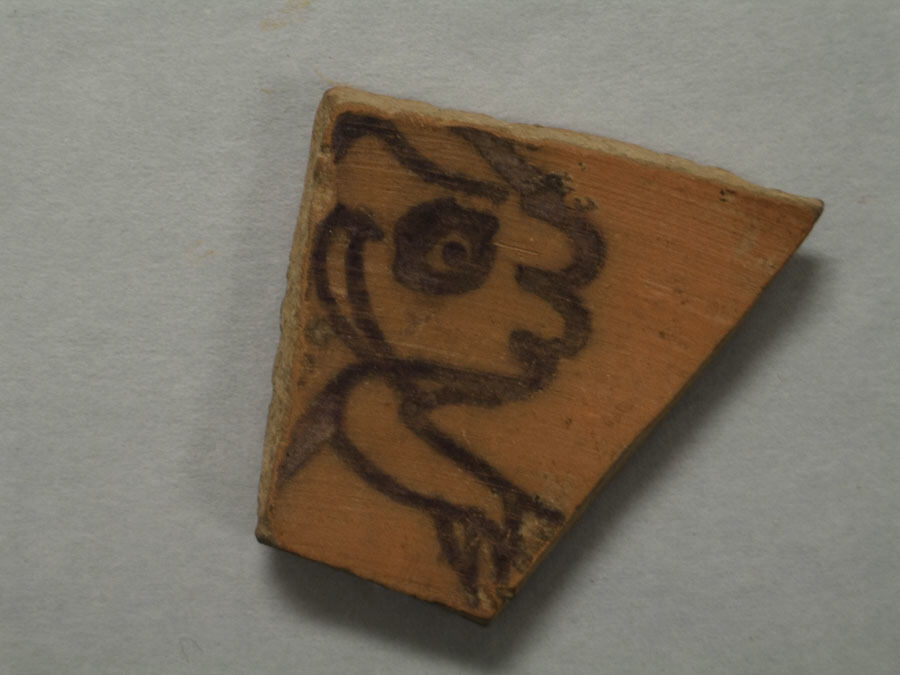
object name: shard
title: Shard: Head of Figure(?)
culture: pakistani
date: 301-500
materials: terracotta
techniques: painting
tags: gandhara